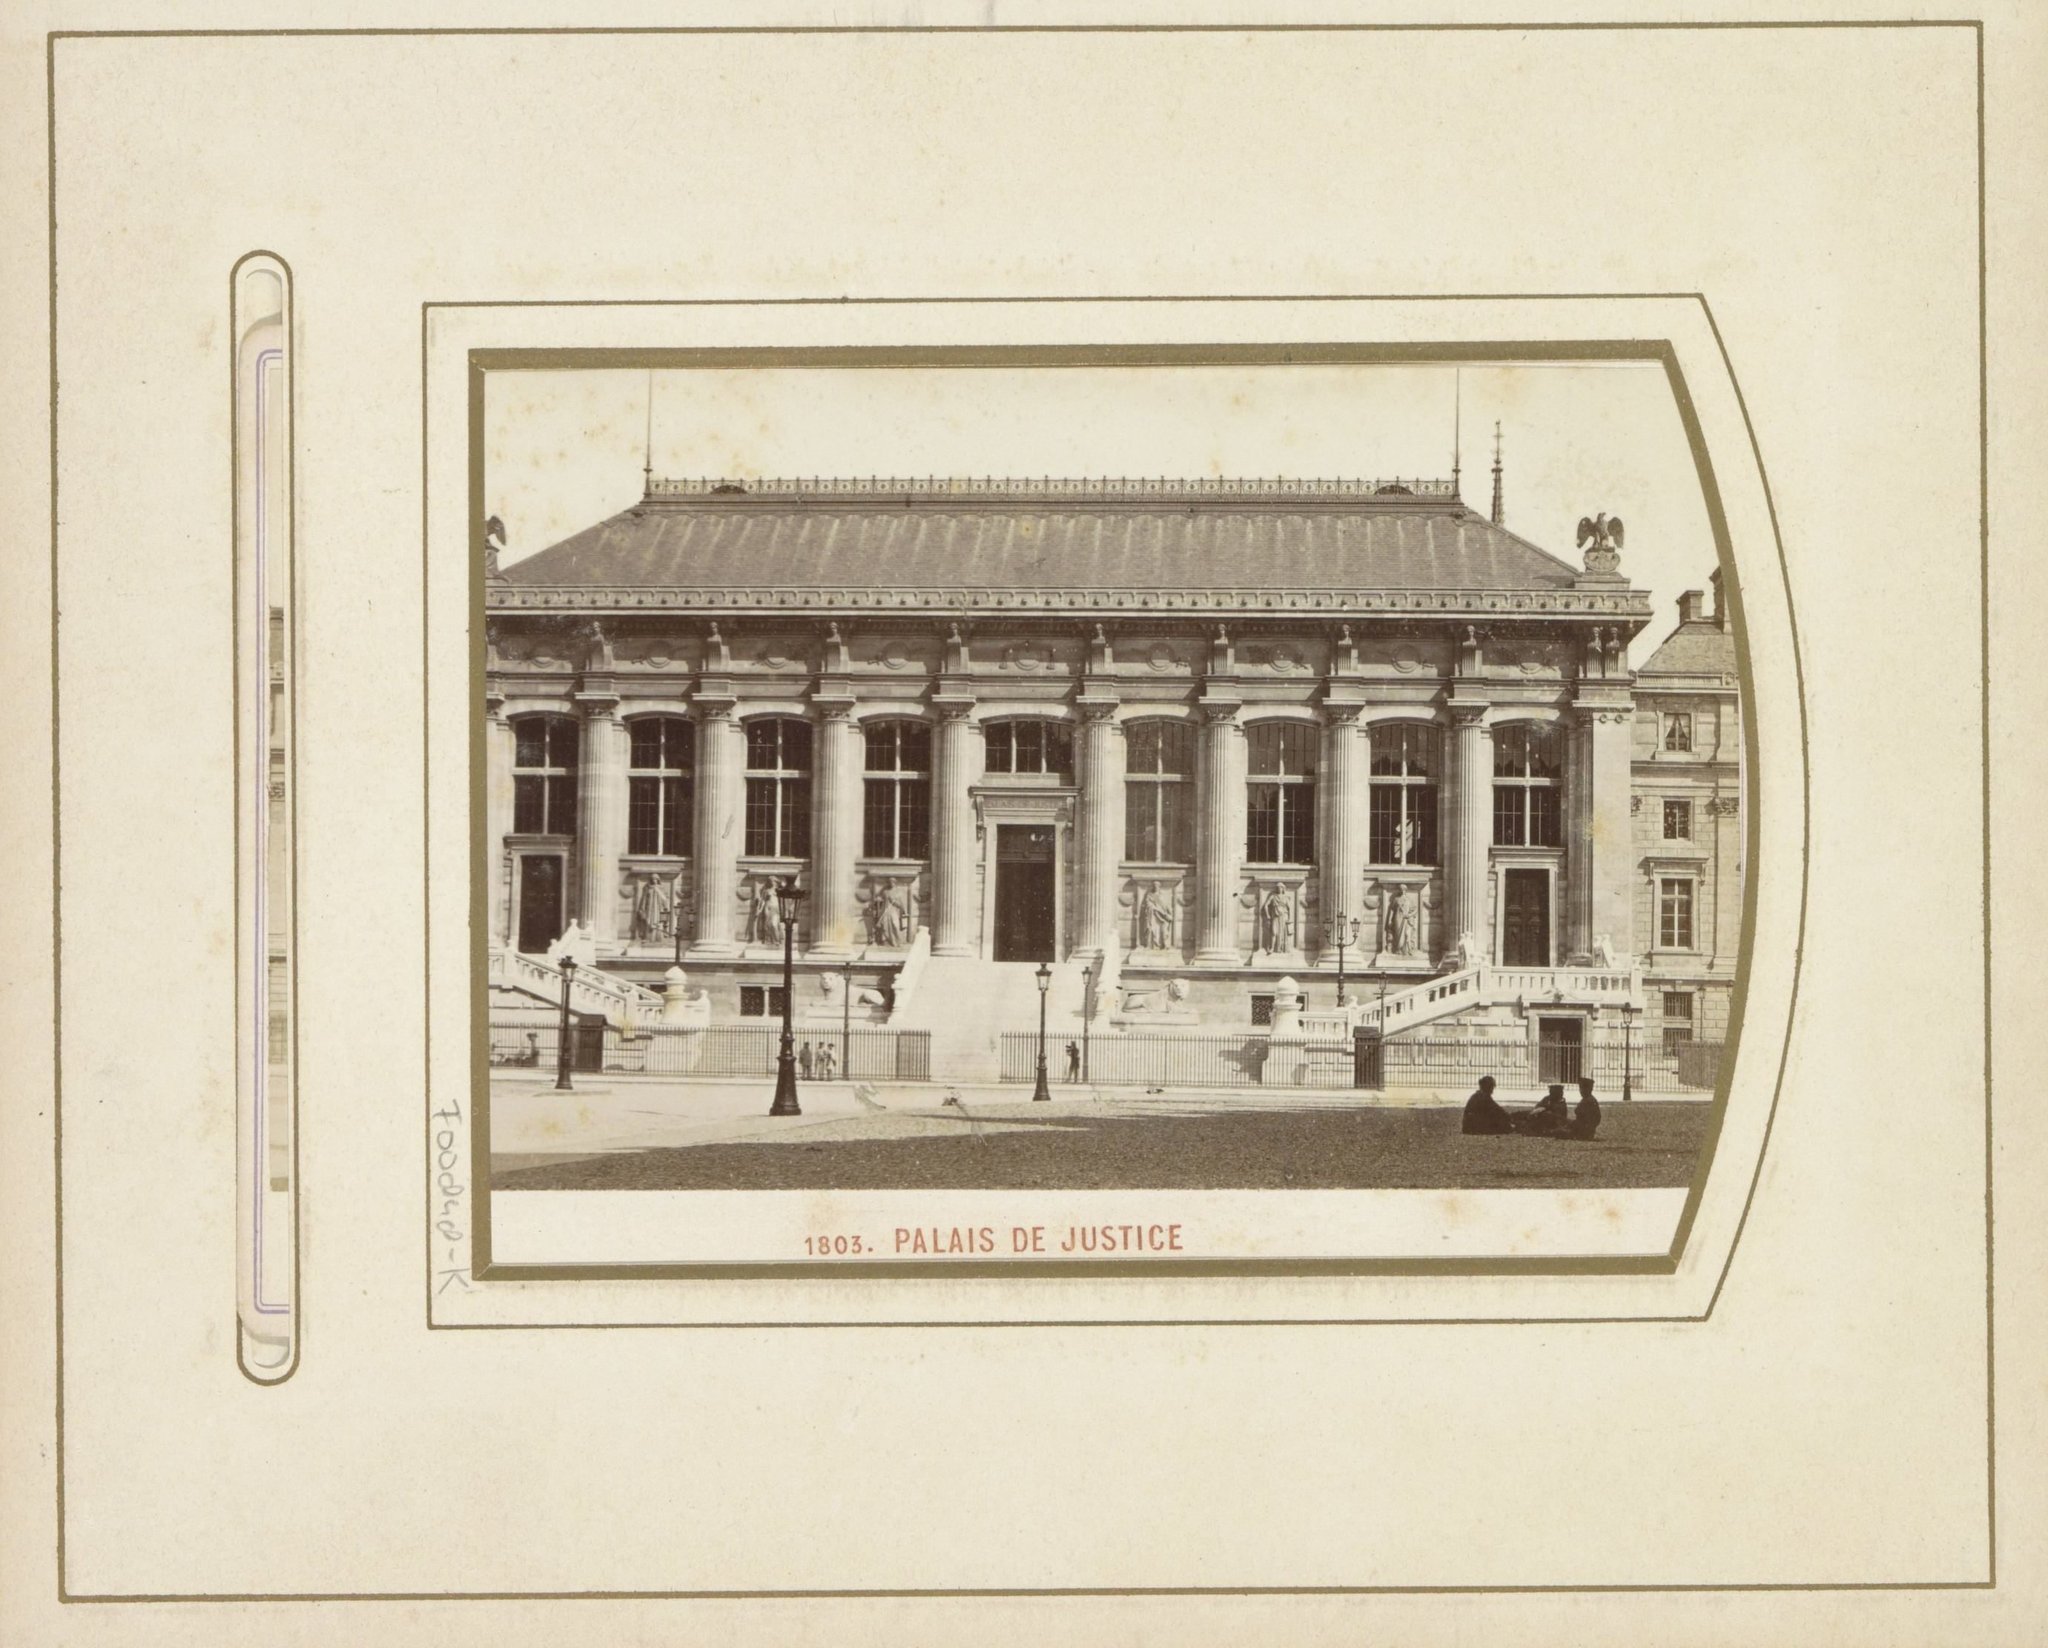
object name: photograph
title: Exterieur van het Palais de Justice in Parijs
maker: ernest ladrey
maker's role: fotograaf, illustrator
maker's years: 1830-1889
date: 1870-1900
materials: cardboard, paper, photographic support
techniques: albumen print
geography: paris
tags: court building, paris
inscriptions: address: ‘Passage des Princes PARIS.’, number: ‘1803.’, inscription: ‘Maison Martinet Albert Hautecoeur 12, Bd des Capucines’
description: Onderdeel van Fotoalbum met kabinetfoto's van bezienswaardigheden in Parijs en Versailles.